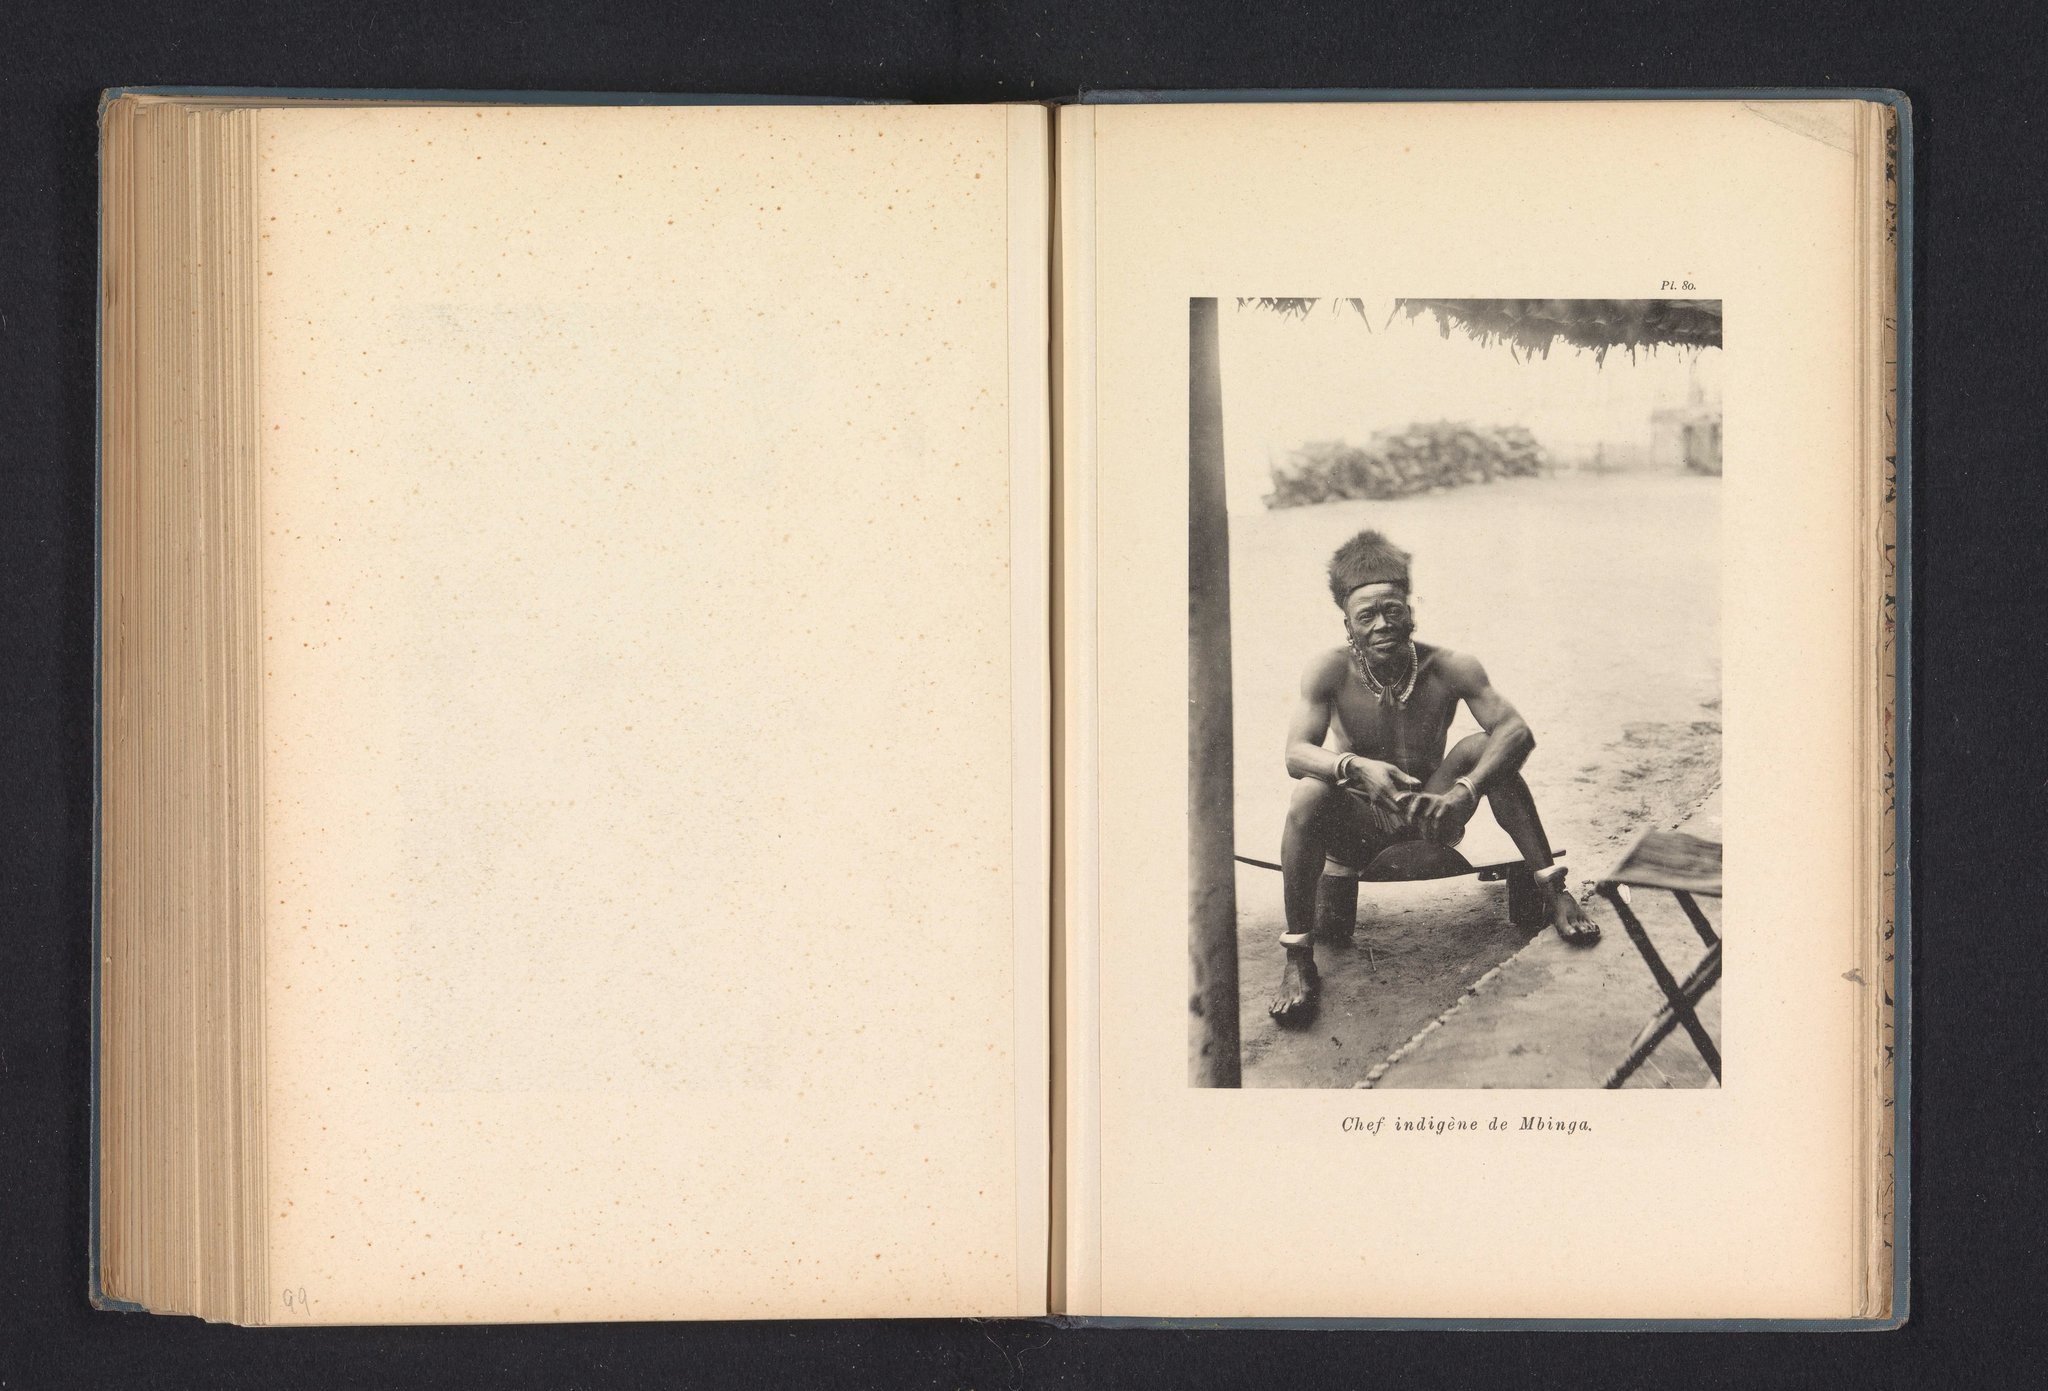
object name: photomechanical print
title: Chef indigène de Mbinga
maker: franz thonner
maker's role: botanicus, ontdekkingsreiziger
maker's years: 1863-1928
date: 1896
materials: paper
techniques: photograph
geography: mbinga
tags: ruler, sovereign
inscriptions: number: ‘Pl. 80.’